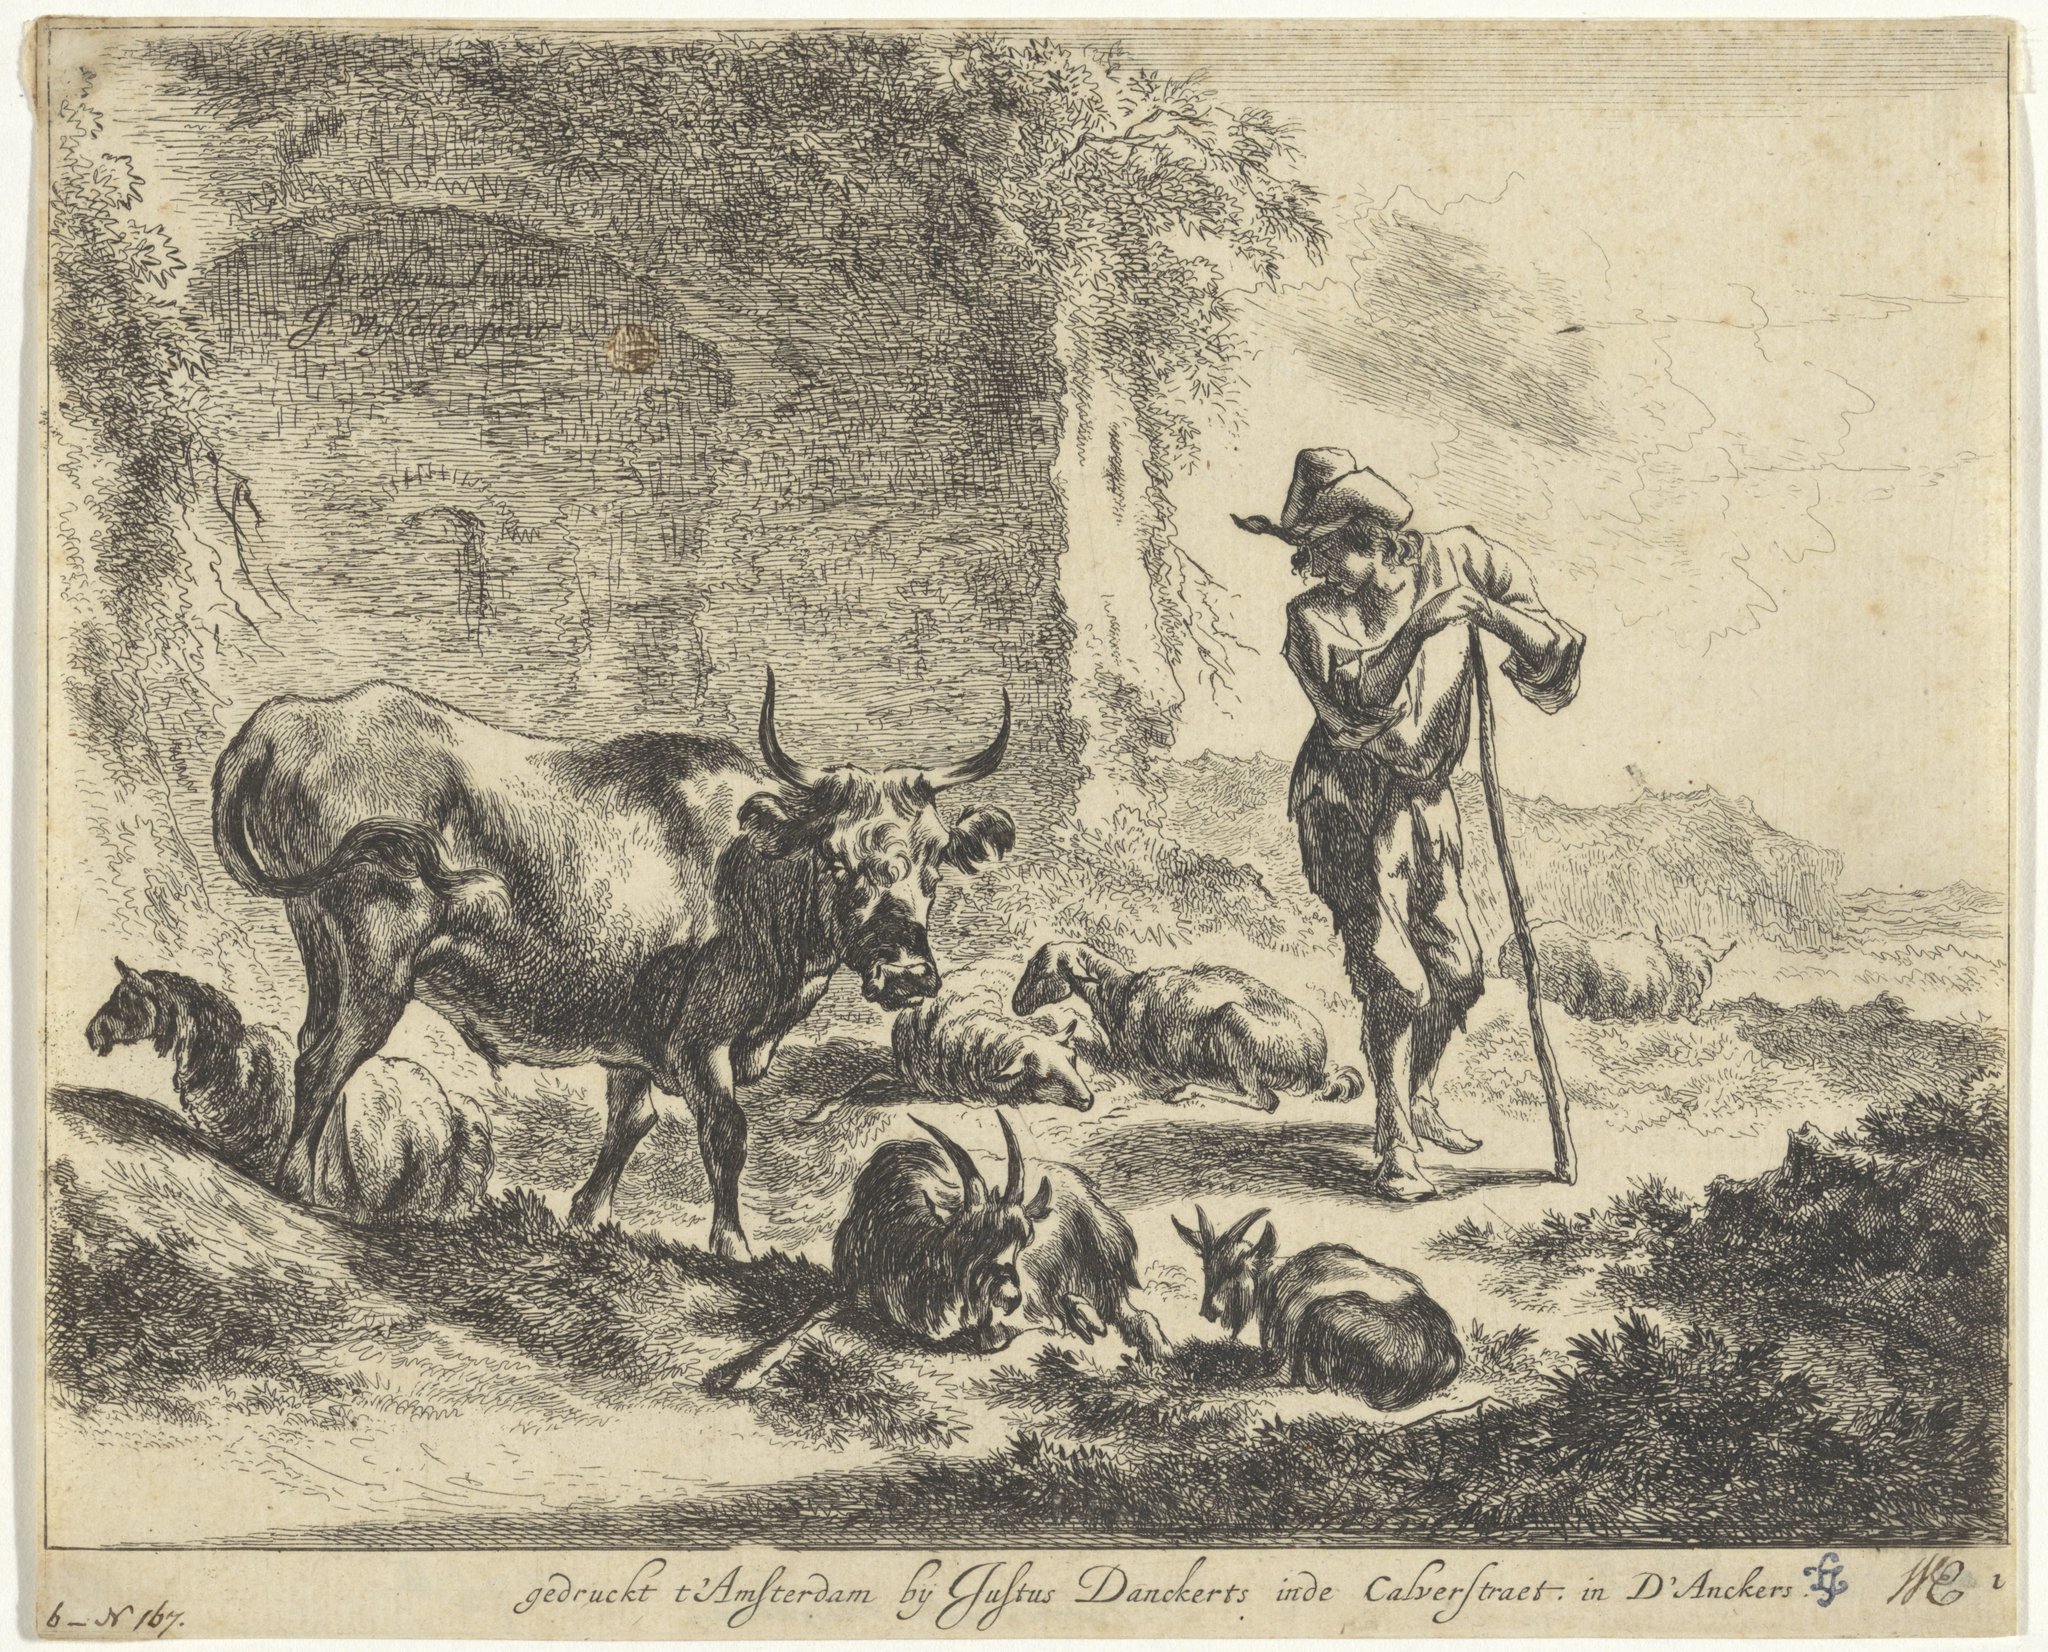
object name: print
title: Landschappen met herders en vee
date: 1650-1701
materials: paper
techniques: engraving, etching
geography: amsterdam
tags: cow, herding, herdsman, herdswoman, shepherd, shepherdess, cowherd, etc., landscape with ruins, goat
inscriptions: collector's mark: Lugt 2617, collector's mark: Lugt 2228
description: In een landschap bij een ruïne staat een herder tussen zijn vee, leunend op zijn staf. Titelprent voor een reeks van zes landschappen met herders en vee.